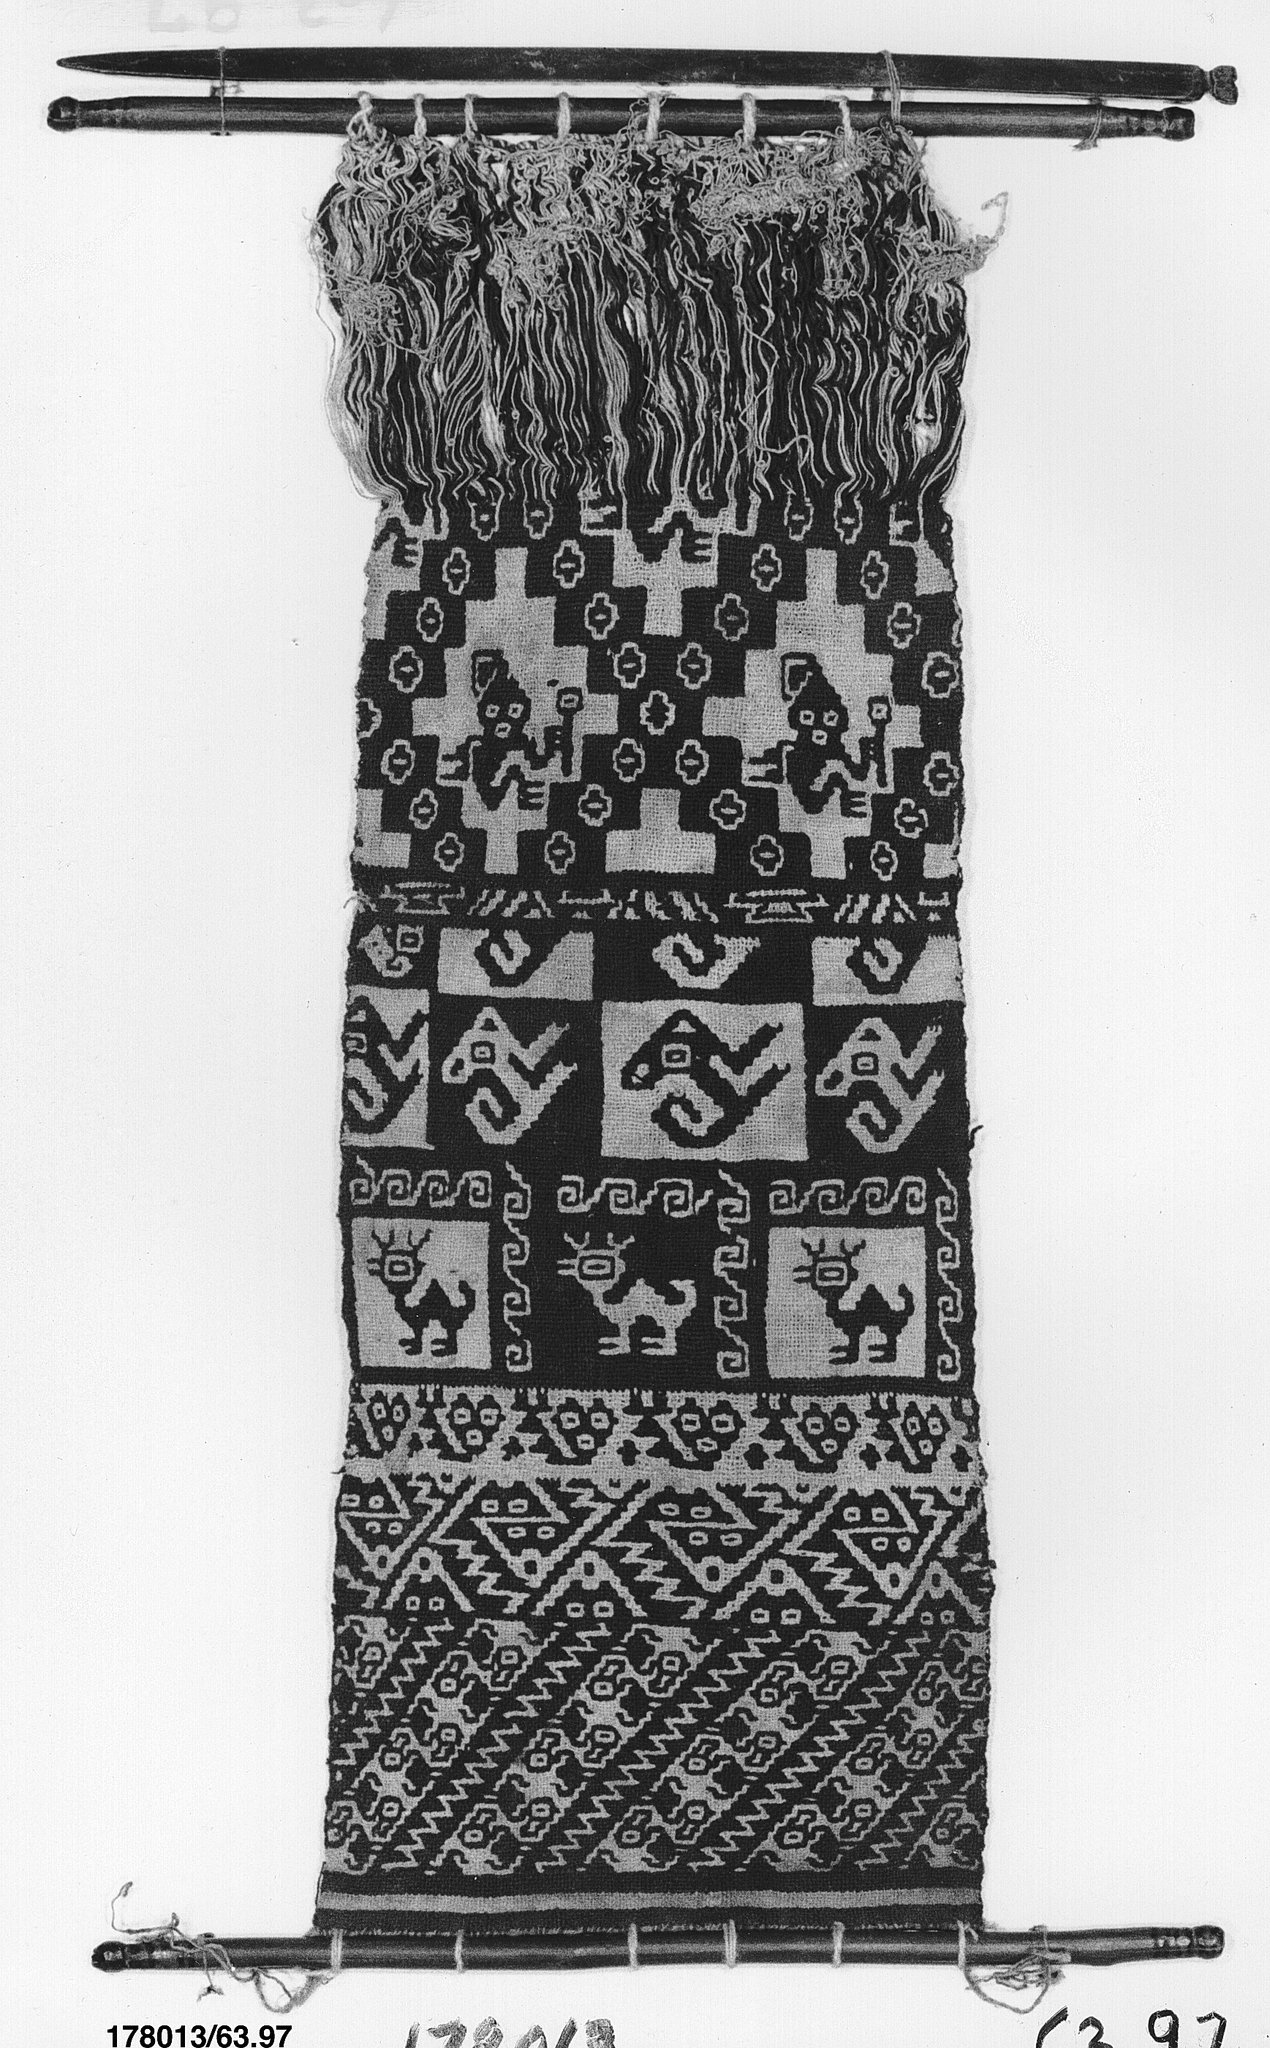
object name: sampler with loom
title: Unfinished Sampler Panel on Loom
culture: peruvian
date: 901-1500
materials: animal fiber, cotton, wood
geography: peru